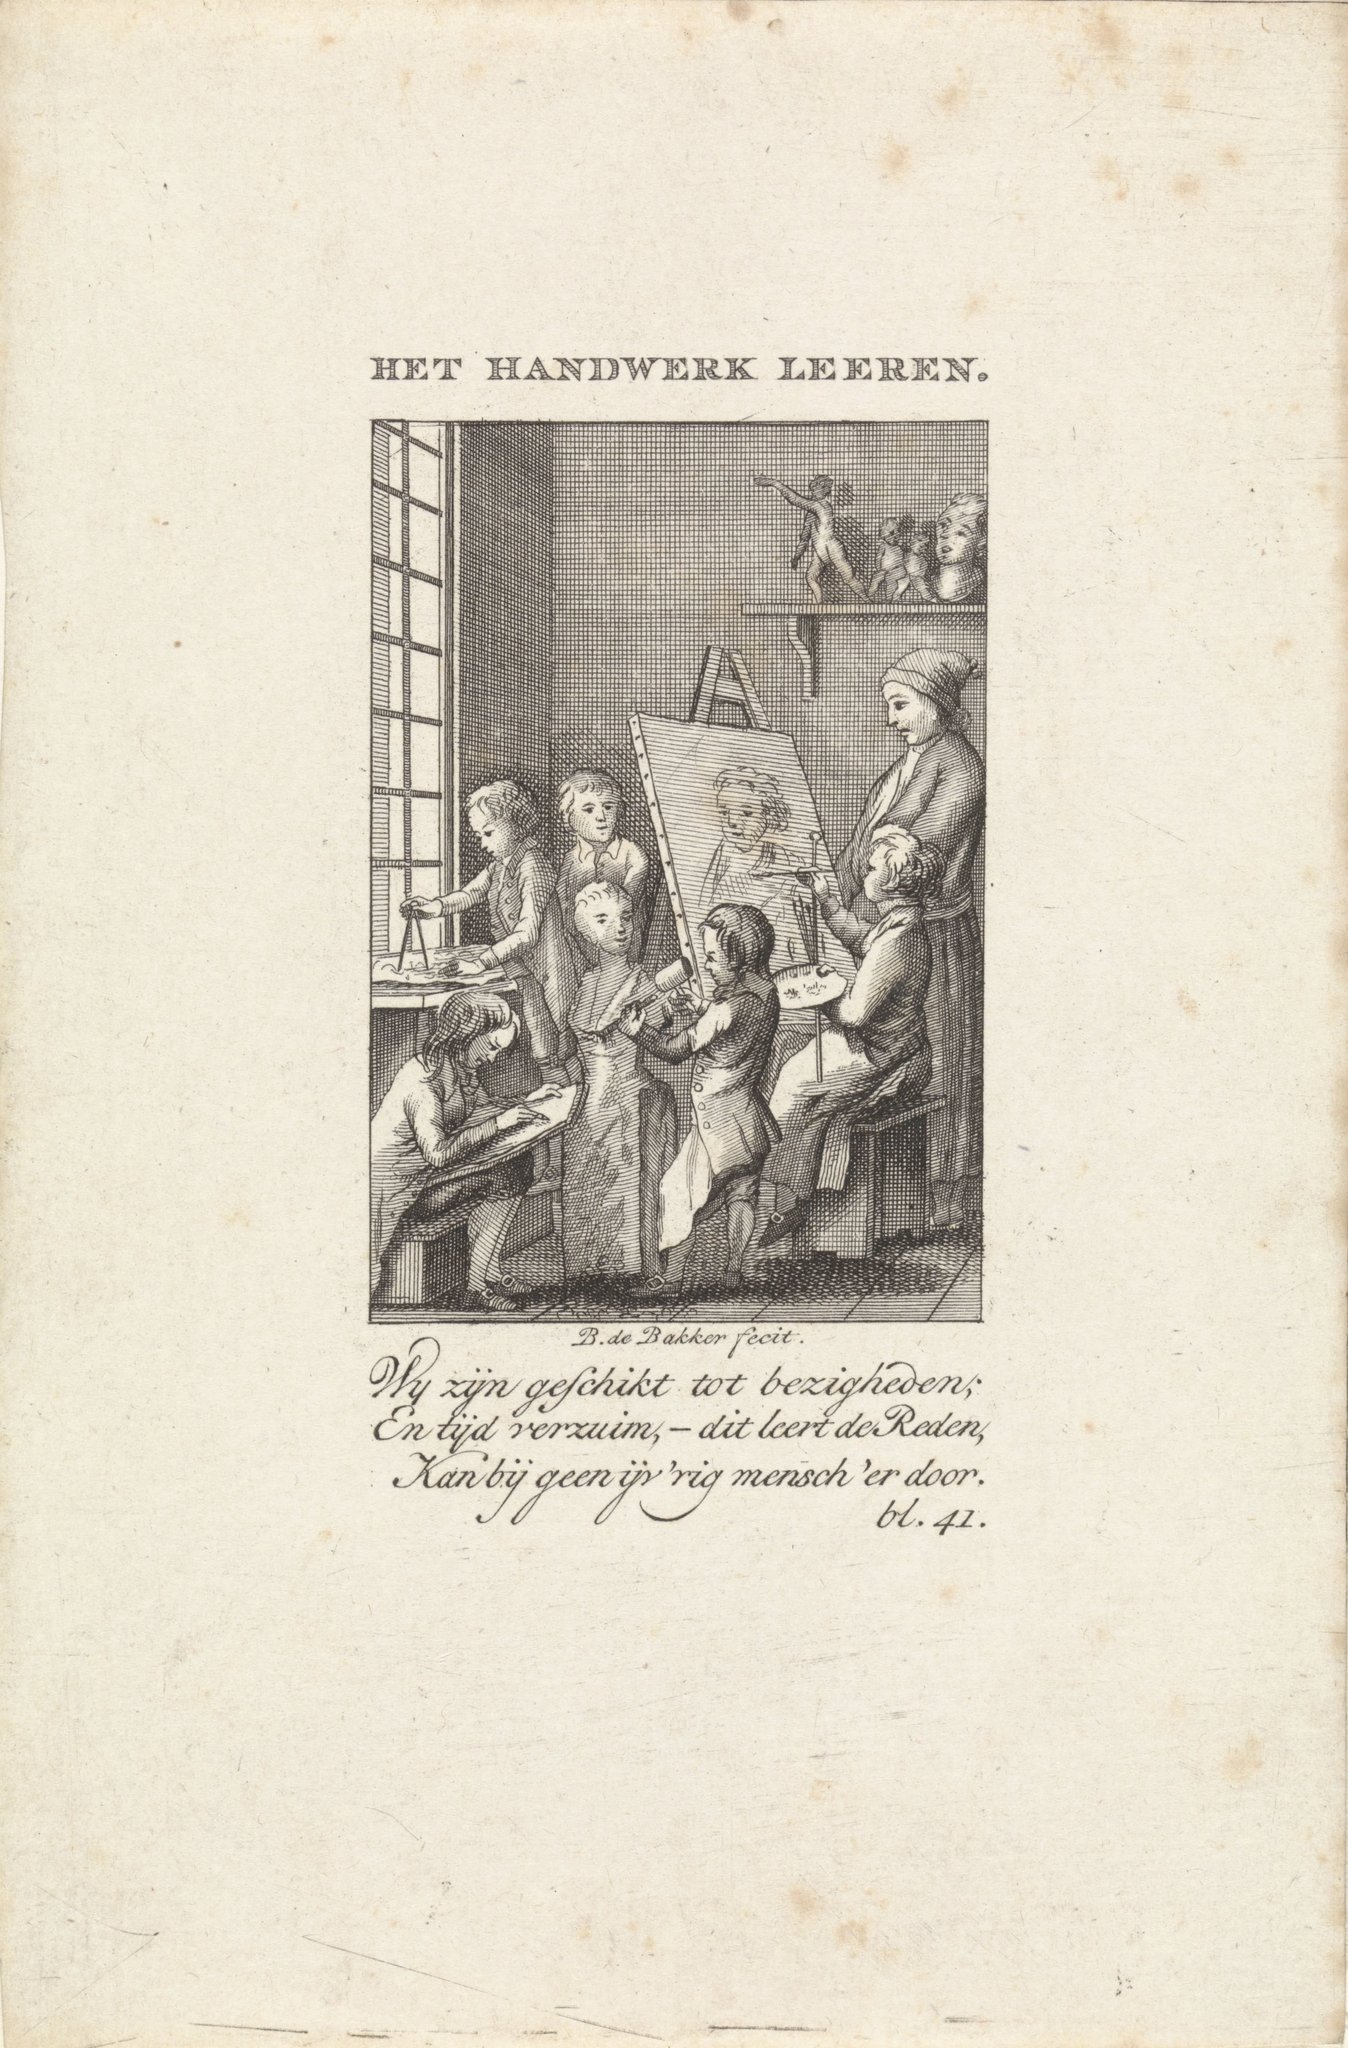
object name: print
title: Kinderpligt en zinnebeelden 2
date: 1789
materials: paper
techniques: engraving, etching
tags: child, drawing-lesson, education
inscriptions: collector's mark: Lugt 2228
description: Prent uit: Hazeu, Johannes Cornelisz., Agt kunstplaaten behoorende tot de Kinderpligt en zinnebeelden, Willem van Vliet (uitgever), Amsterdam 1789.